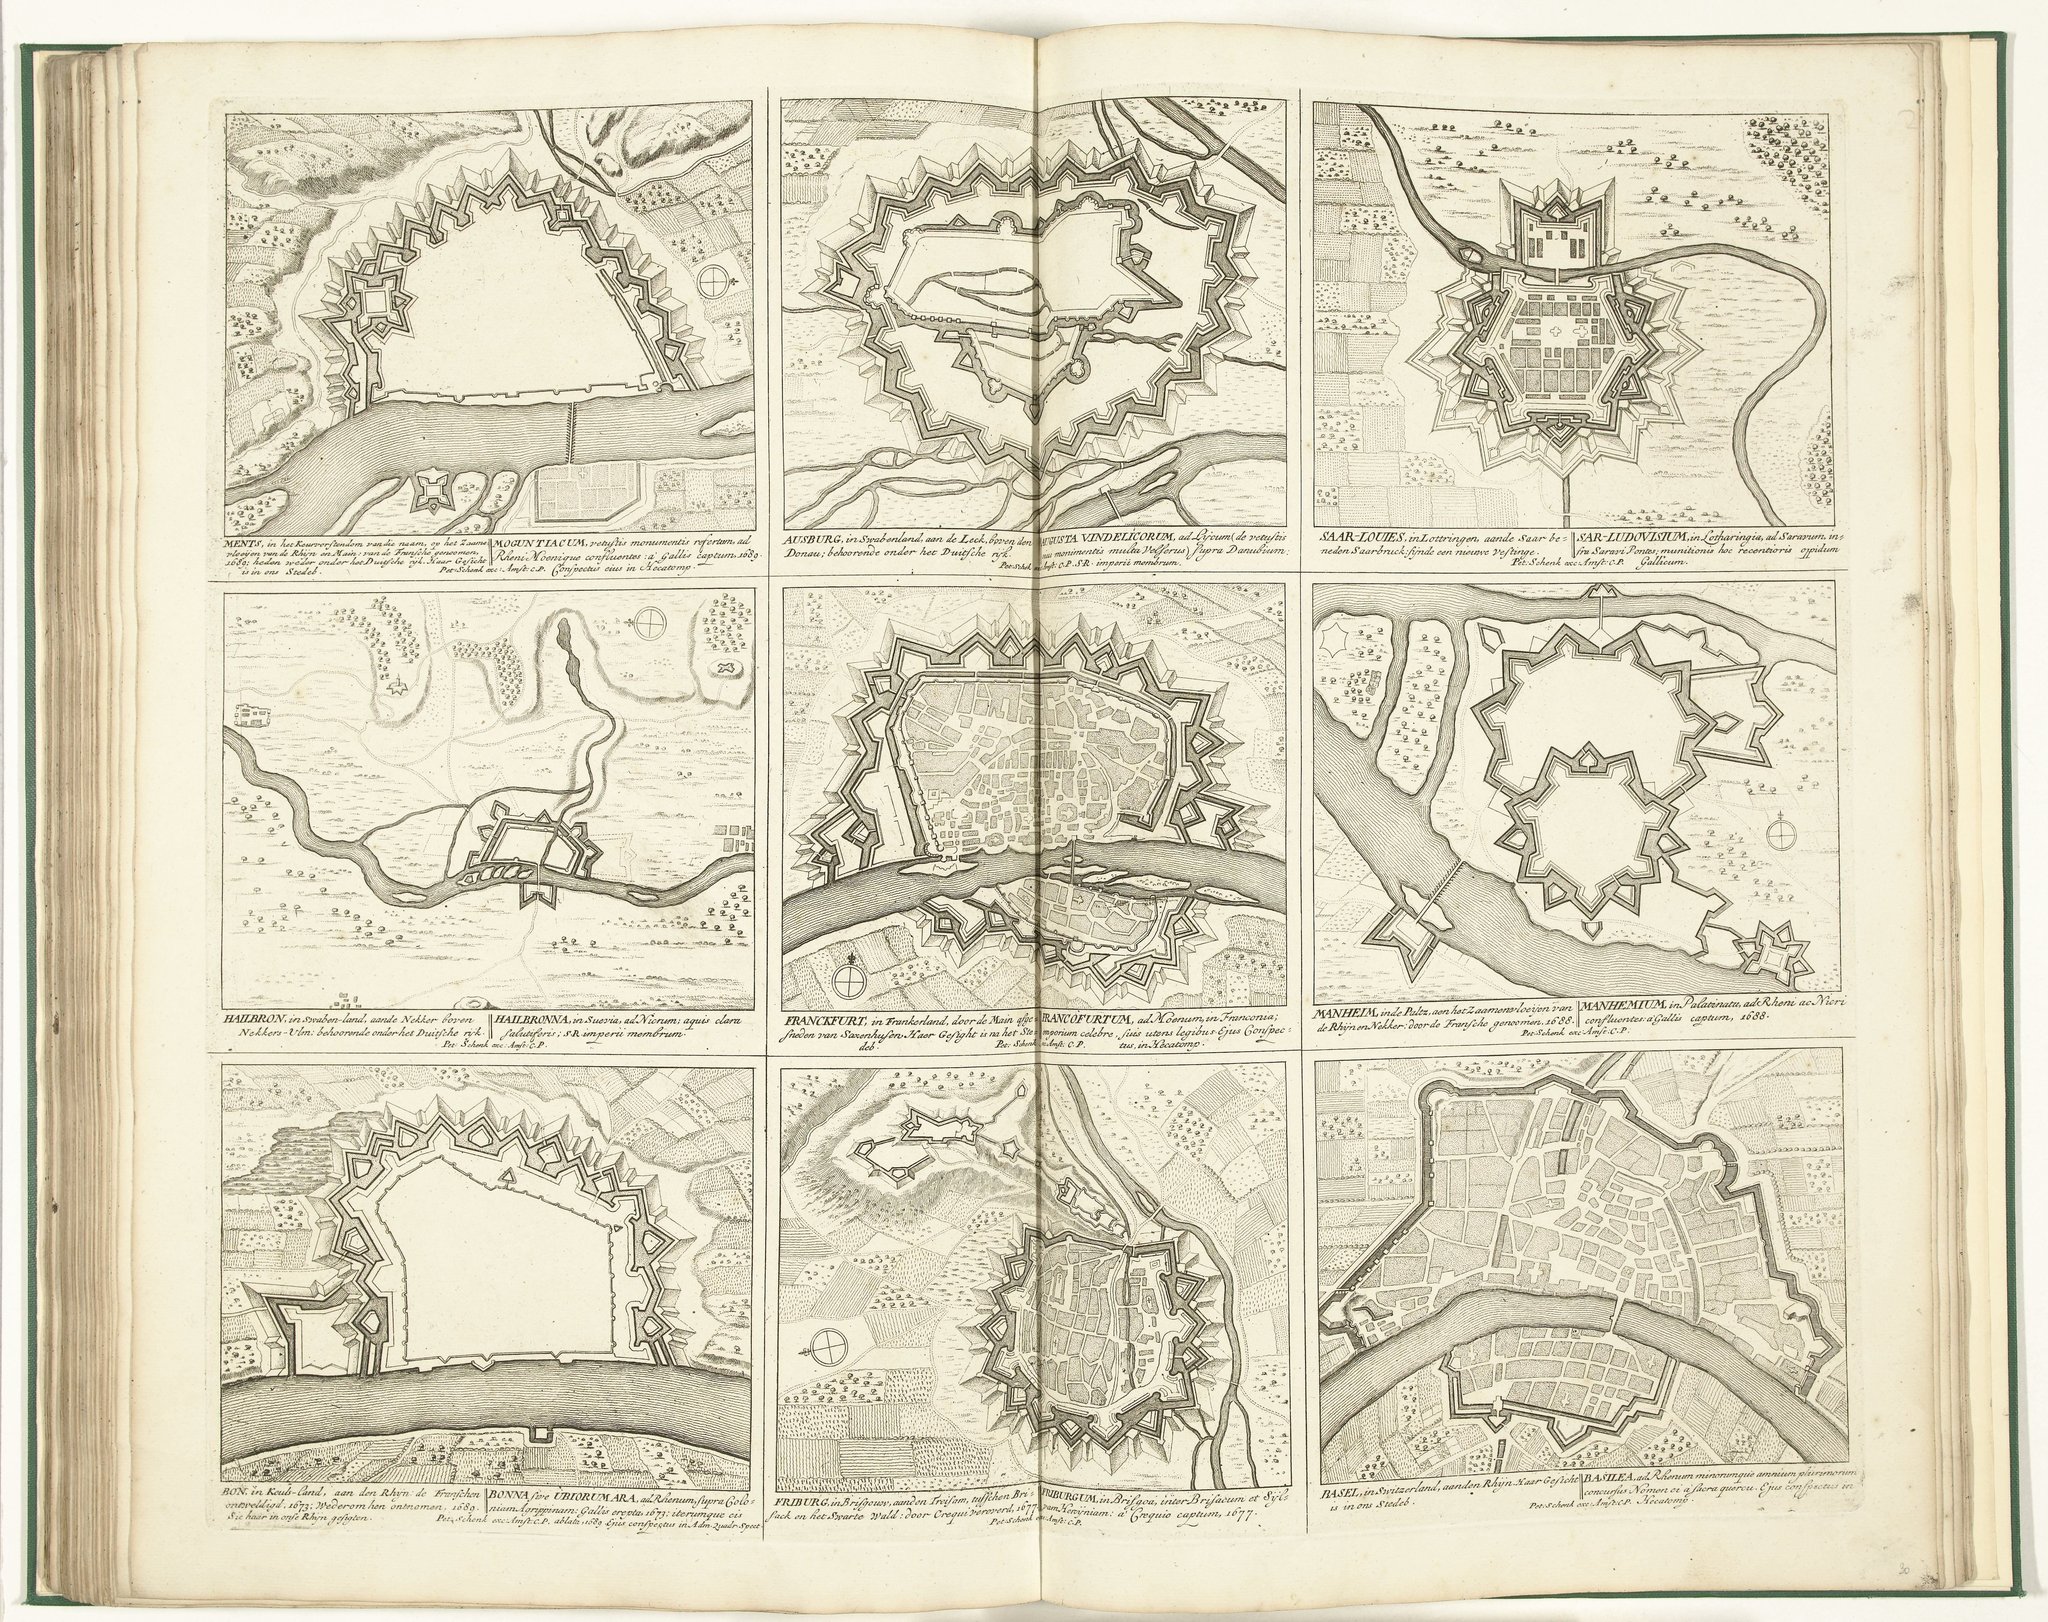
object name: print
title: Schouwburg van den oorlog (blad XXX), ca. 1700-1710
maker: pieter schenk (i)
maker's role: print maker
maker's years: 1660-1711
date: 1700-1710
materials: paper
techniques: etching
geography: amsterdam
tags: fortress, maps of cities, augsburg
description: Blad met negen plattegronden van versterkte steden. Blad XXX in: Schouwburg van den oorlog (editie van 1720), het prentwerk met de gebundelde reeks van 31 platen over de Spaanse Successieoorlog.